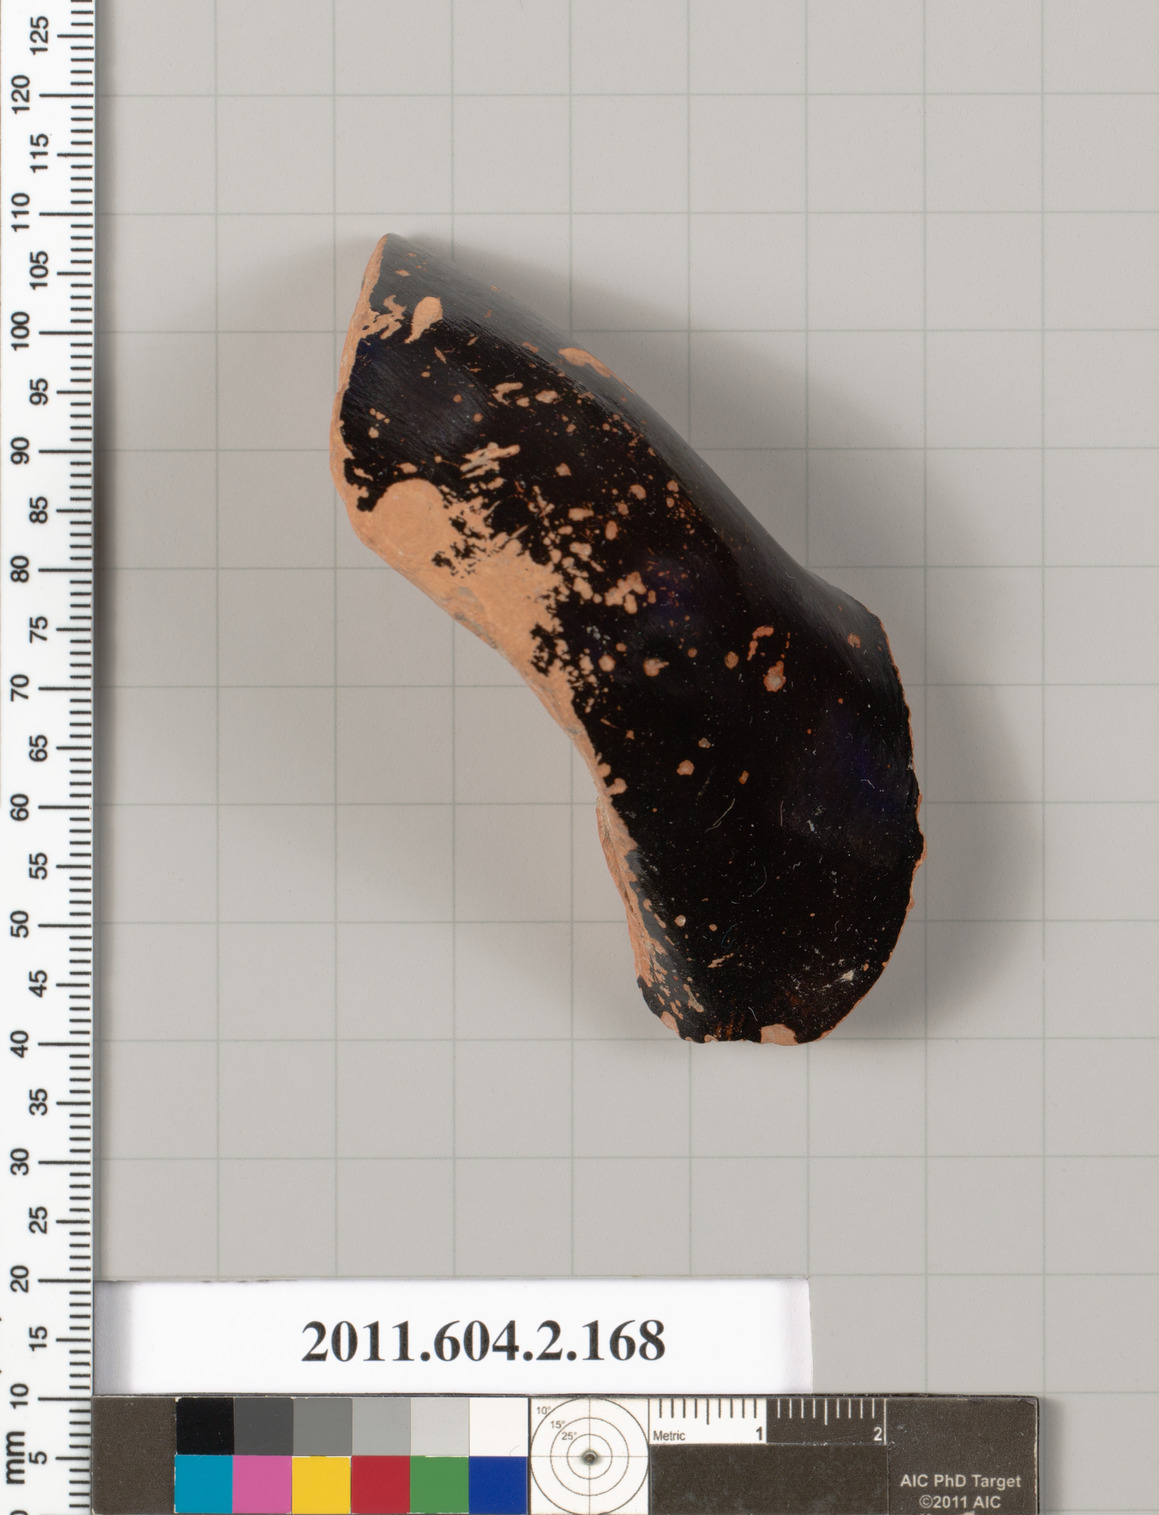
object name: stamnos fragment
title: Terracotta fragment of a stamnos (jar)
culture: greek, attic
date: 470-450 BCE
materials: terracotta